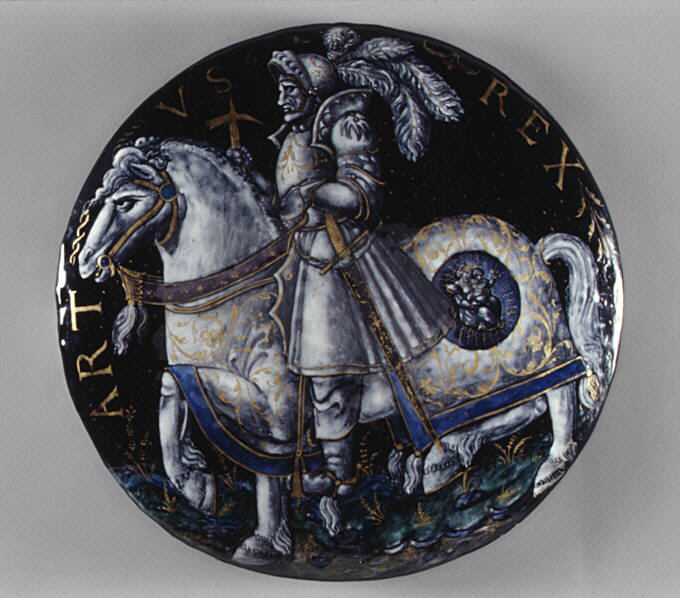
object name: medallion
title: King Arthur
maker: colin nouailher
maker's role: enameler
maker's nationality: french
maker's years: 1471-1571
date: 1541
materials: copper, enamel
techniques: gilding, painting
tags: swords,kings,horses